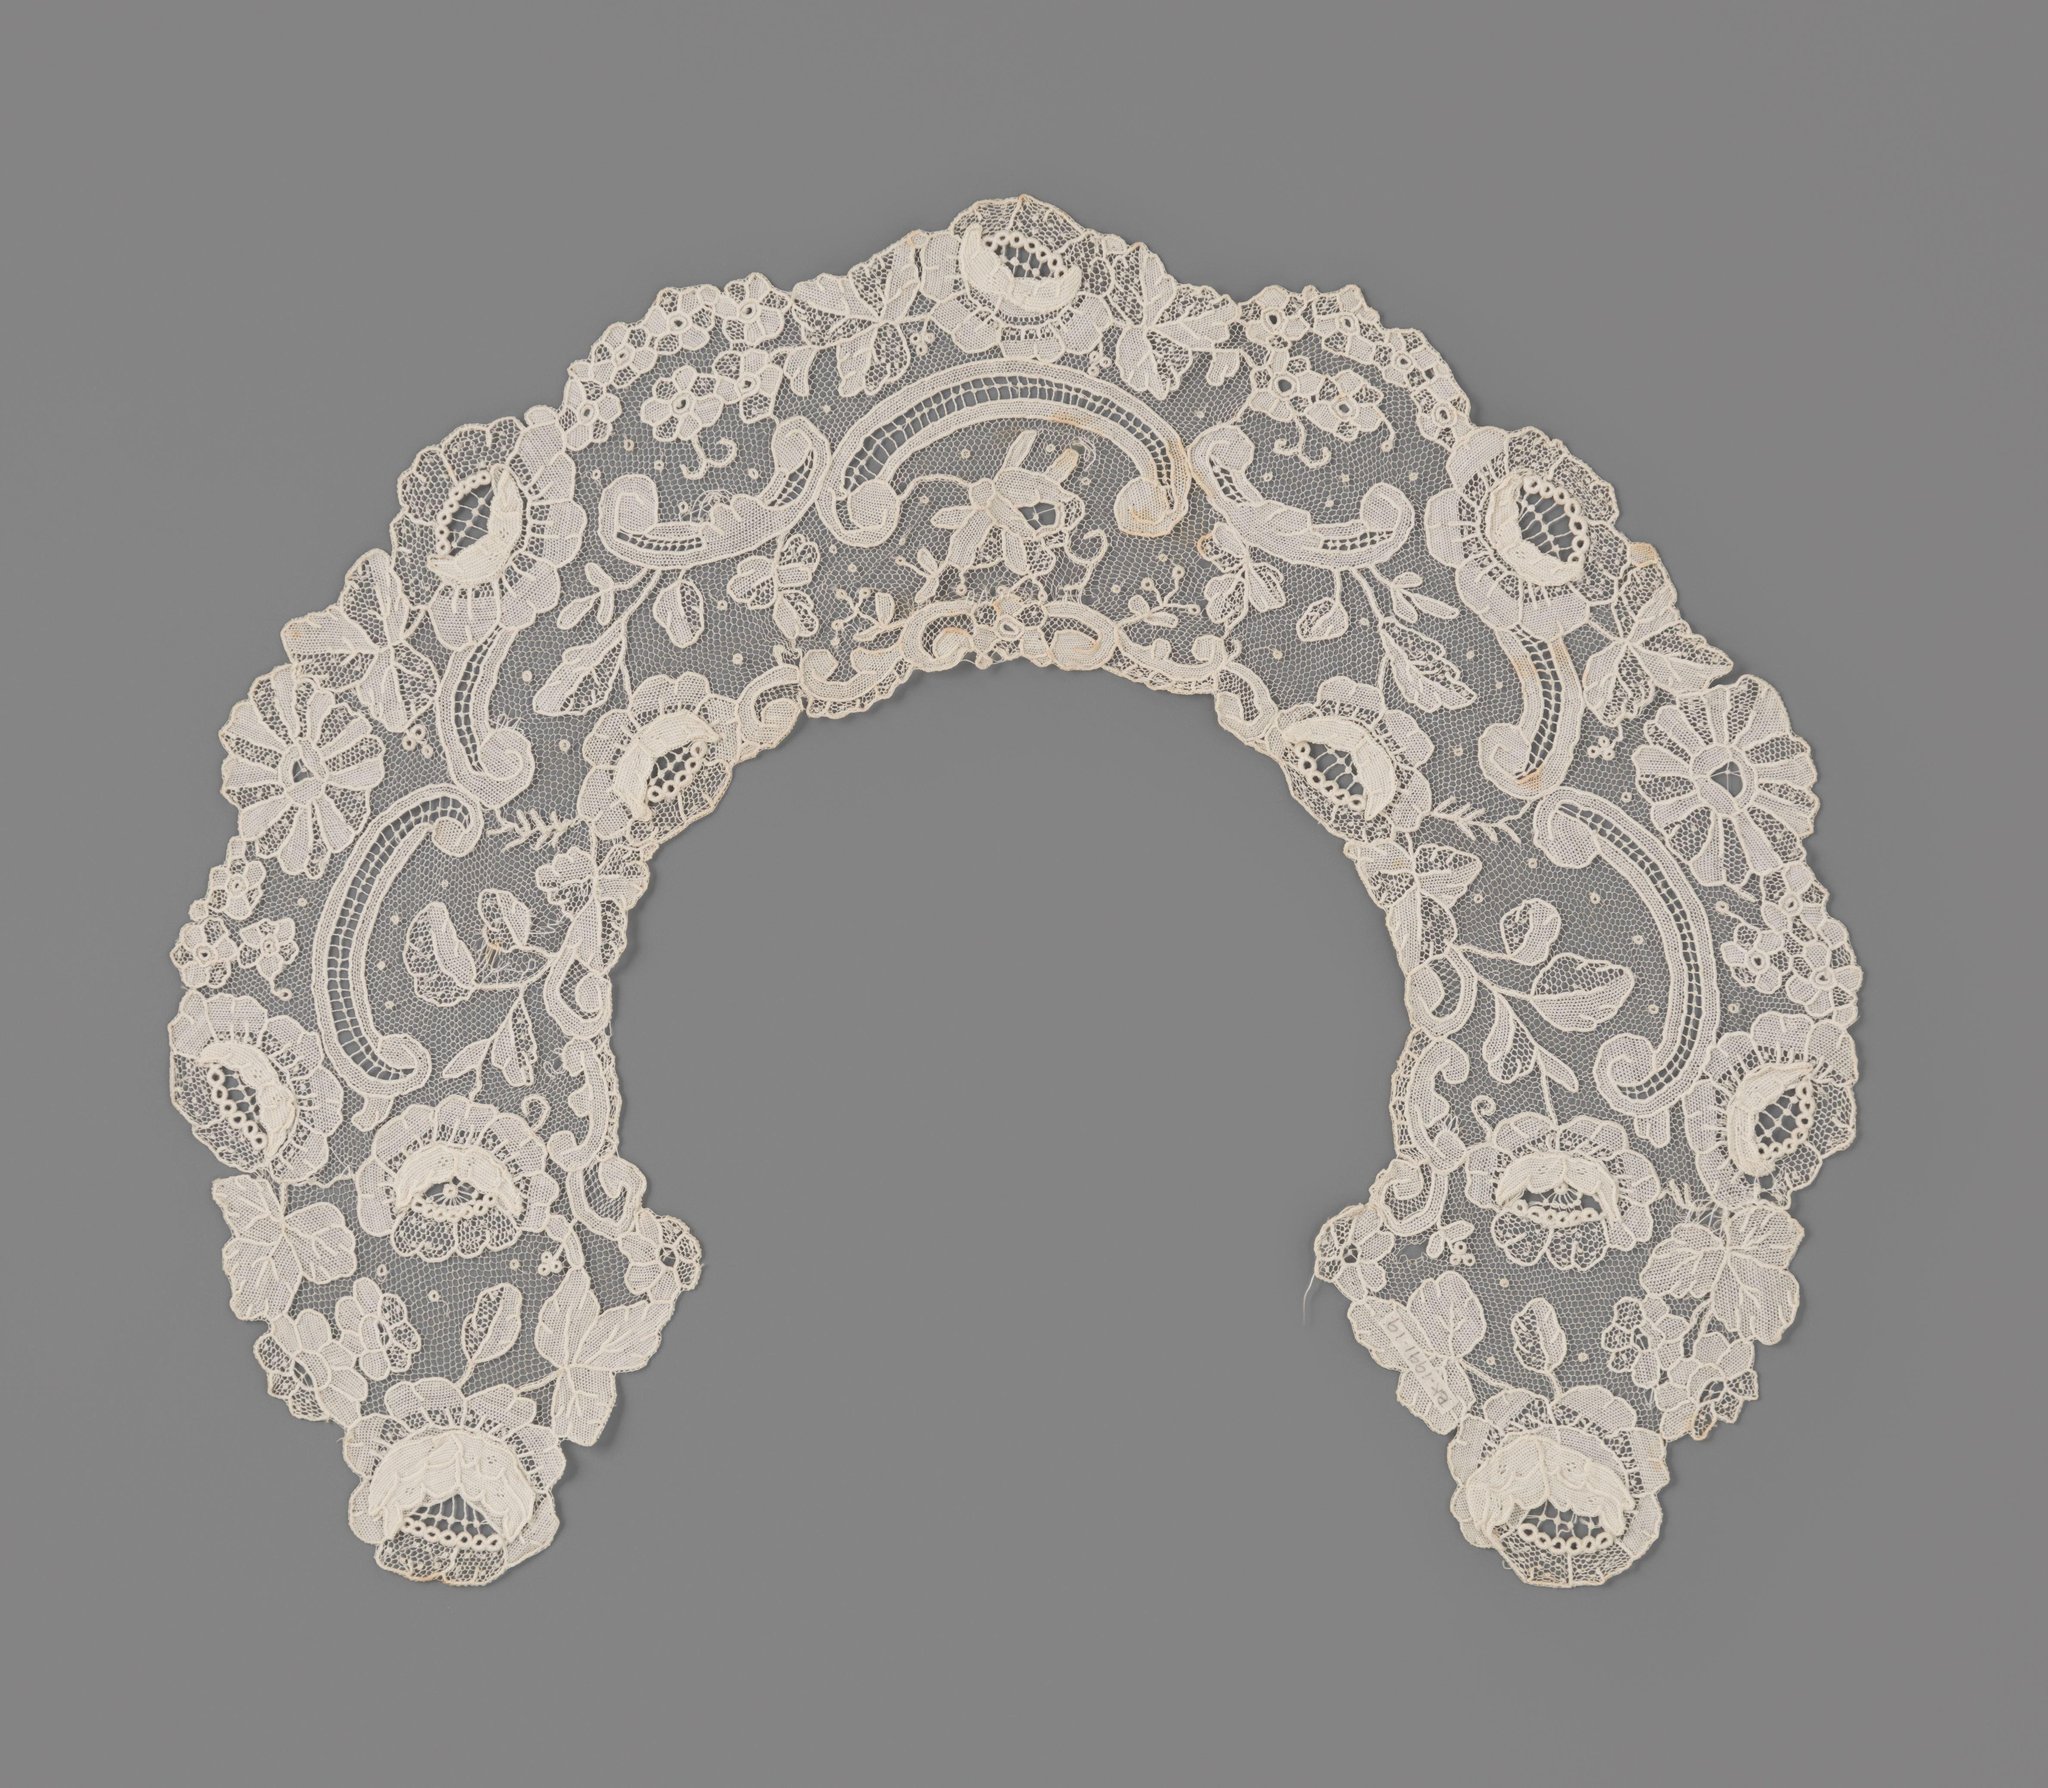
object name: collar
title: Kraag van naaldkant (Brusselse gaaskant)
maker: Anonymous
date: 1900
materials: lace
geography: brussels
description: Ronde kraag van naaldkant. Het patroon bestaat uit C-voluten en bloemen. Langs de geschulpte rand een bloem- en bladrand.